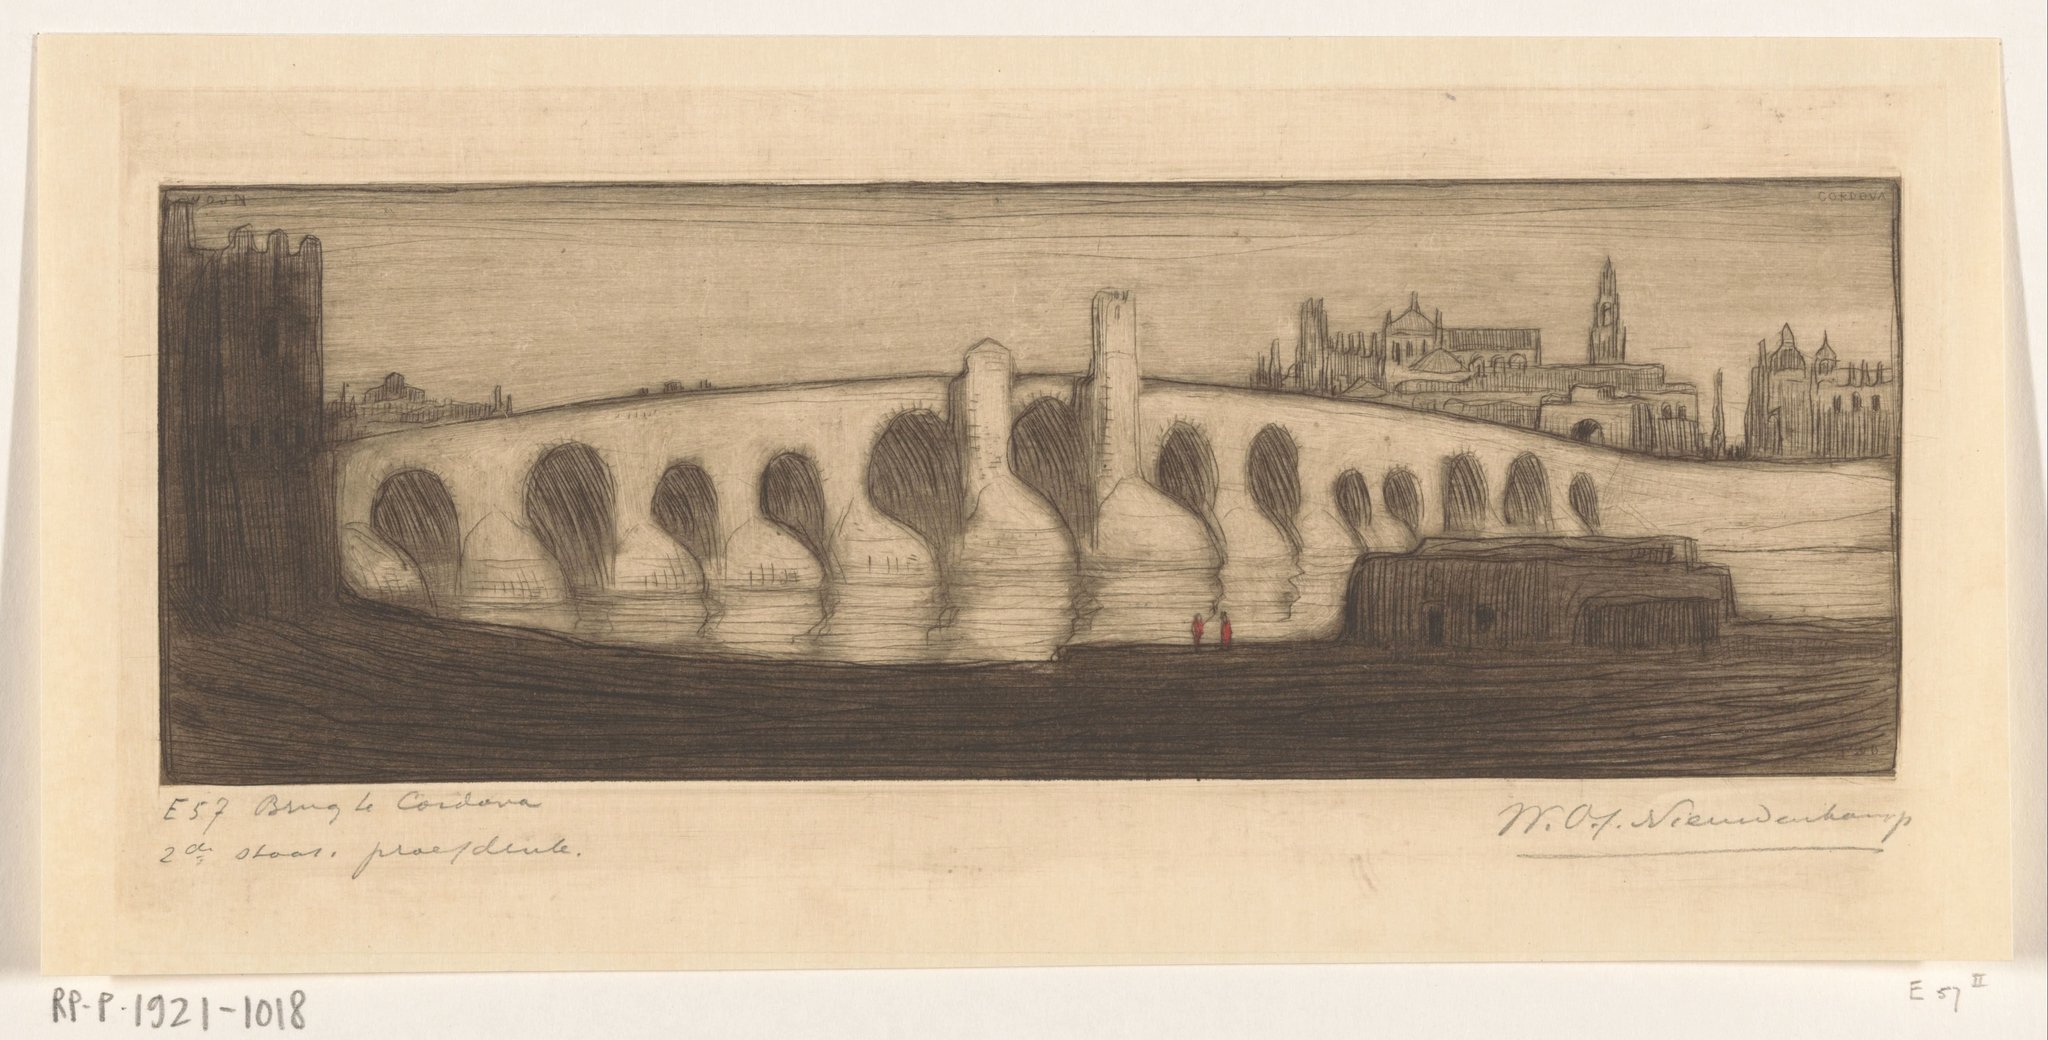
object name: print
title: Romeinse brug over de Guadalquivir in Córdoba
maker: wijnand otto jan nieuwenkamp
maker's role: draughtsman, print maker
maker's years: 1874-1950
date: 1901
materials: paint, paper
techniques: intaglio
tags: bridge in city across river, canal, etc.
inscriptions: collector's mark: Lugt 2233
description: Op de achtergrond de stad Córdoba. Bij deze tweede staat van de prent zijn er op de voorgrond twee figuren toegevoegd.